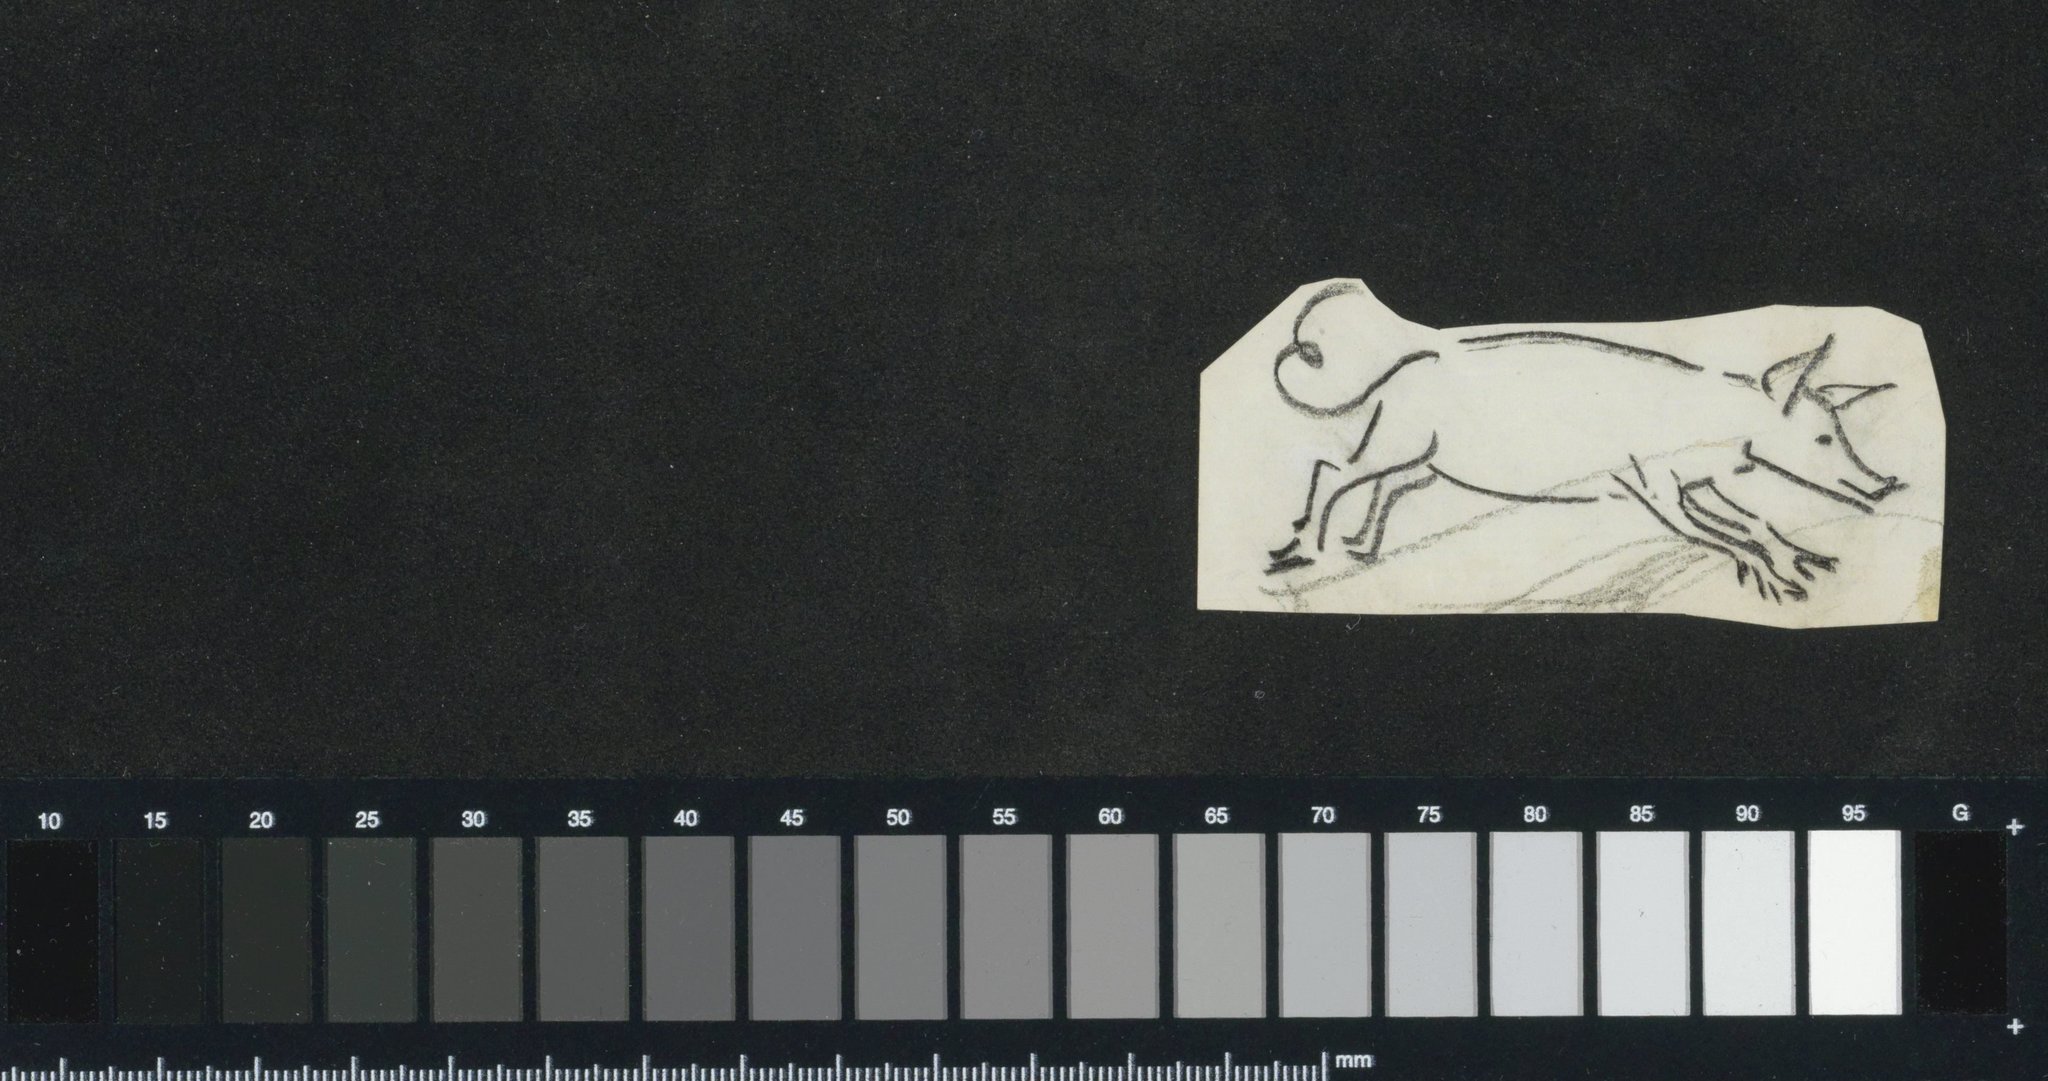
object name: drawing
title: Rennend varken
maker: gerrit willem dijsselhof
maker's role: designer, draughtsman, print maker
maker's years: 1866-1924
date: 1876-1924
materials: chalk, paper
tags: pig